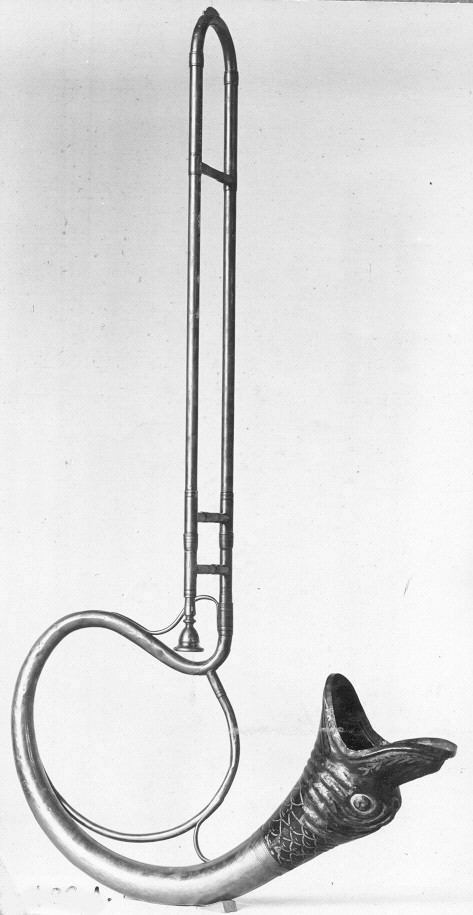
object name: tenor slide trombone in b flat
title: Tenor Trombone in B-flat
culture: european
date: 1801-1833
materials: brass